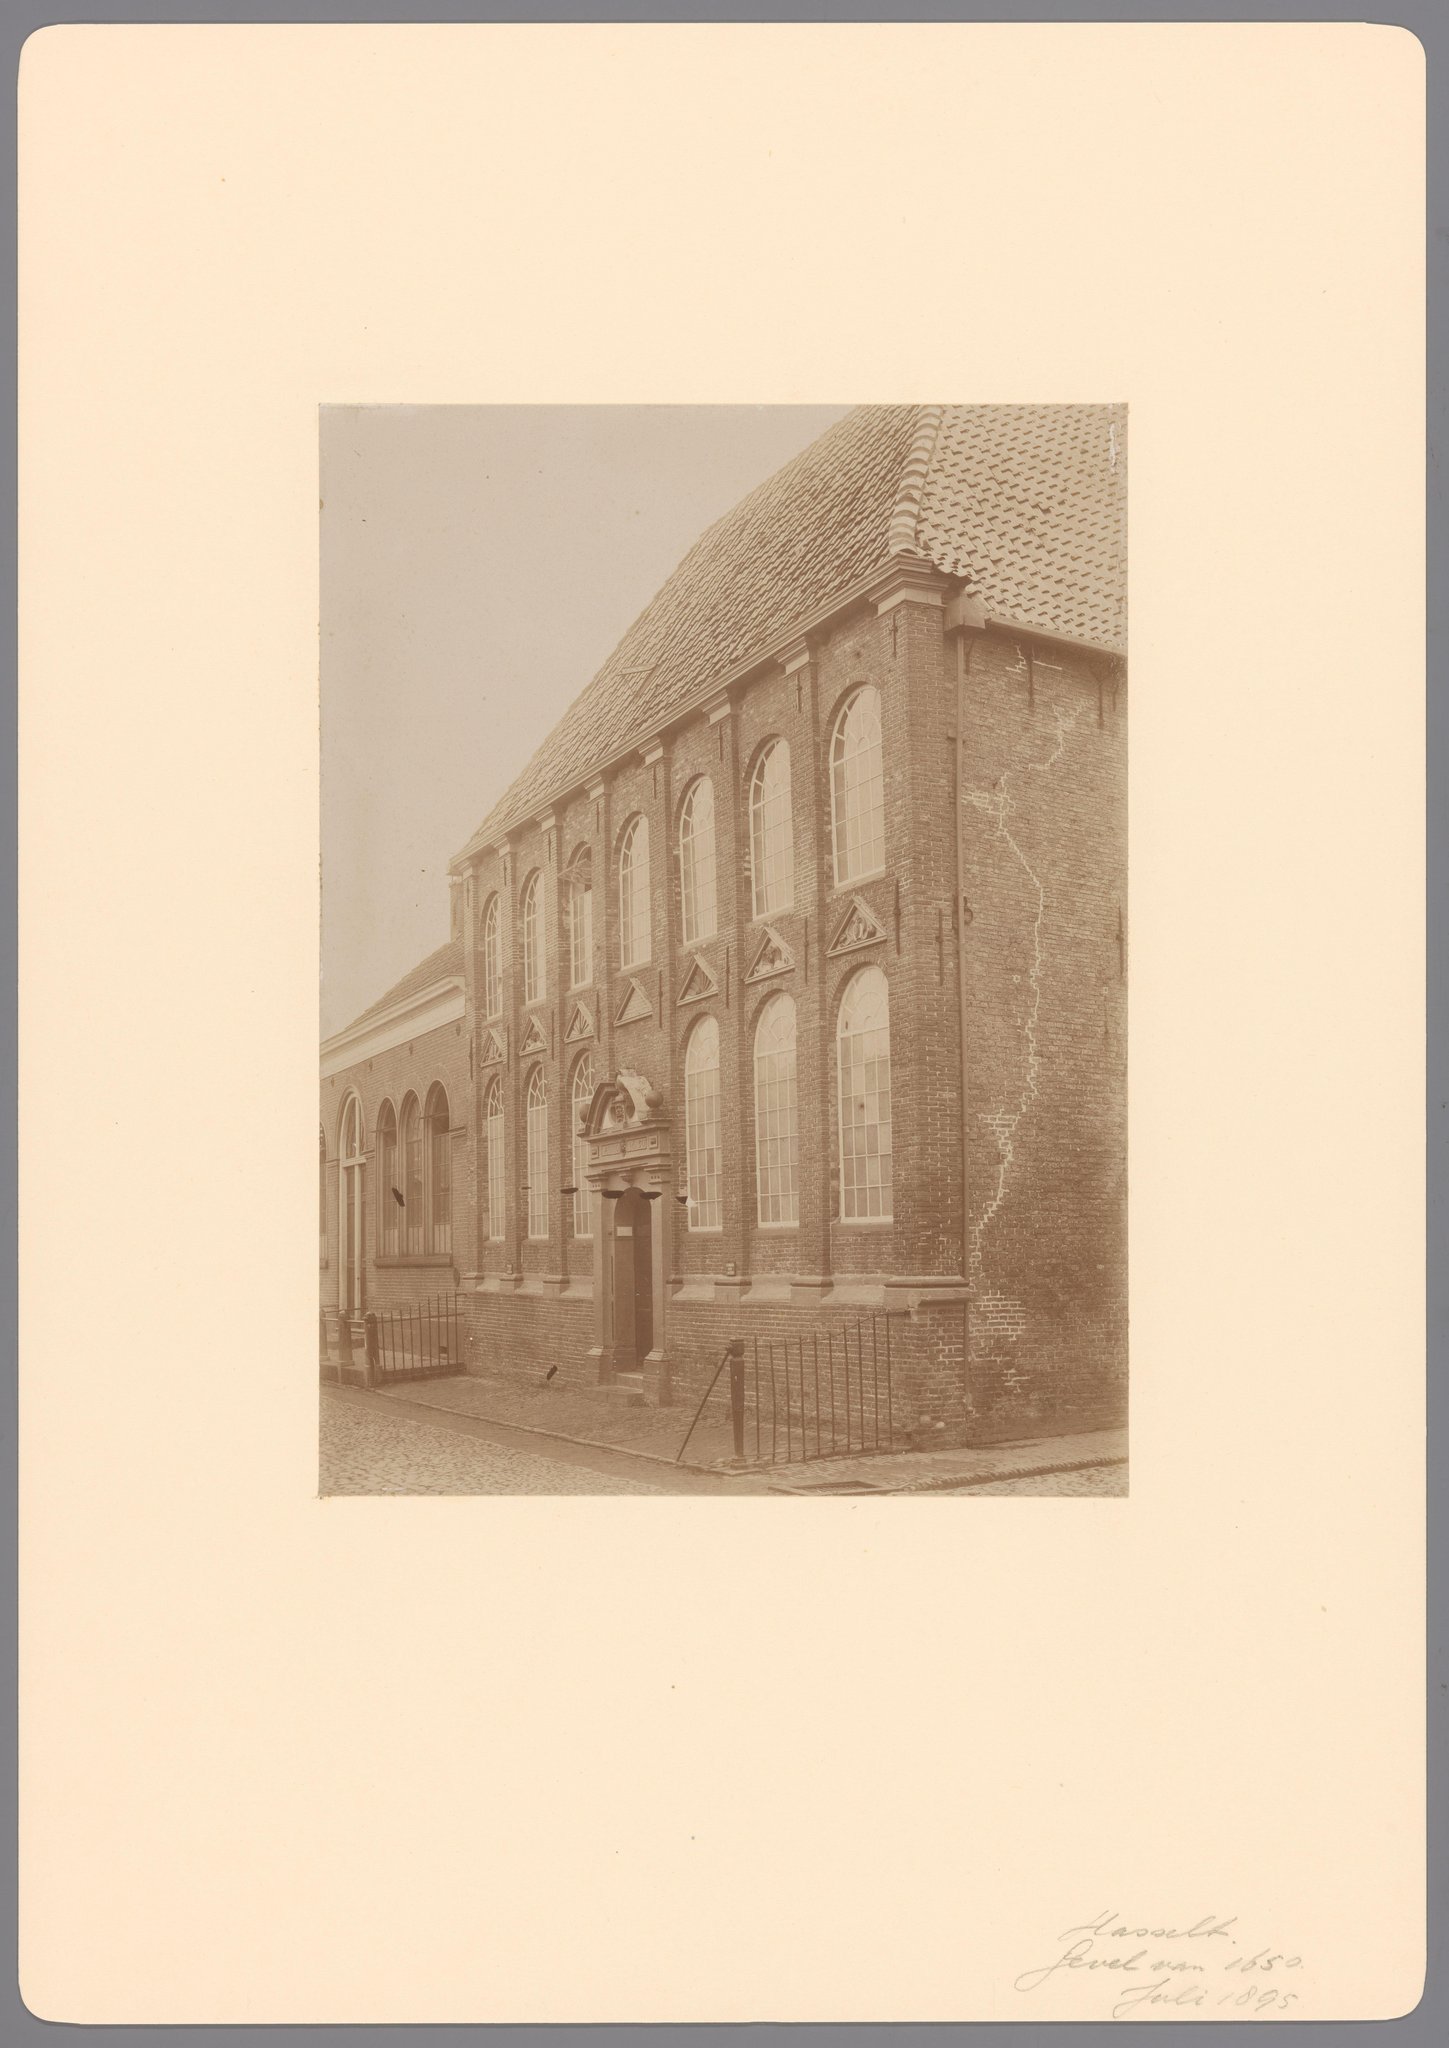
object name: photograph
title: Façade van een pand te Hasselt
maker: anoniem (monumentenzorg)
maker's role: fotograaf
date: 1895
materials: cardboard, photographic support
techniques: collodion silver print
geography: hasselt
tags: façade (of house or building)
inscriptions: annotation: ‘Hasselt/ gevel van 1650/ juli 1895’